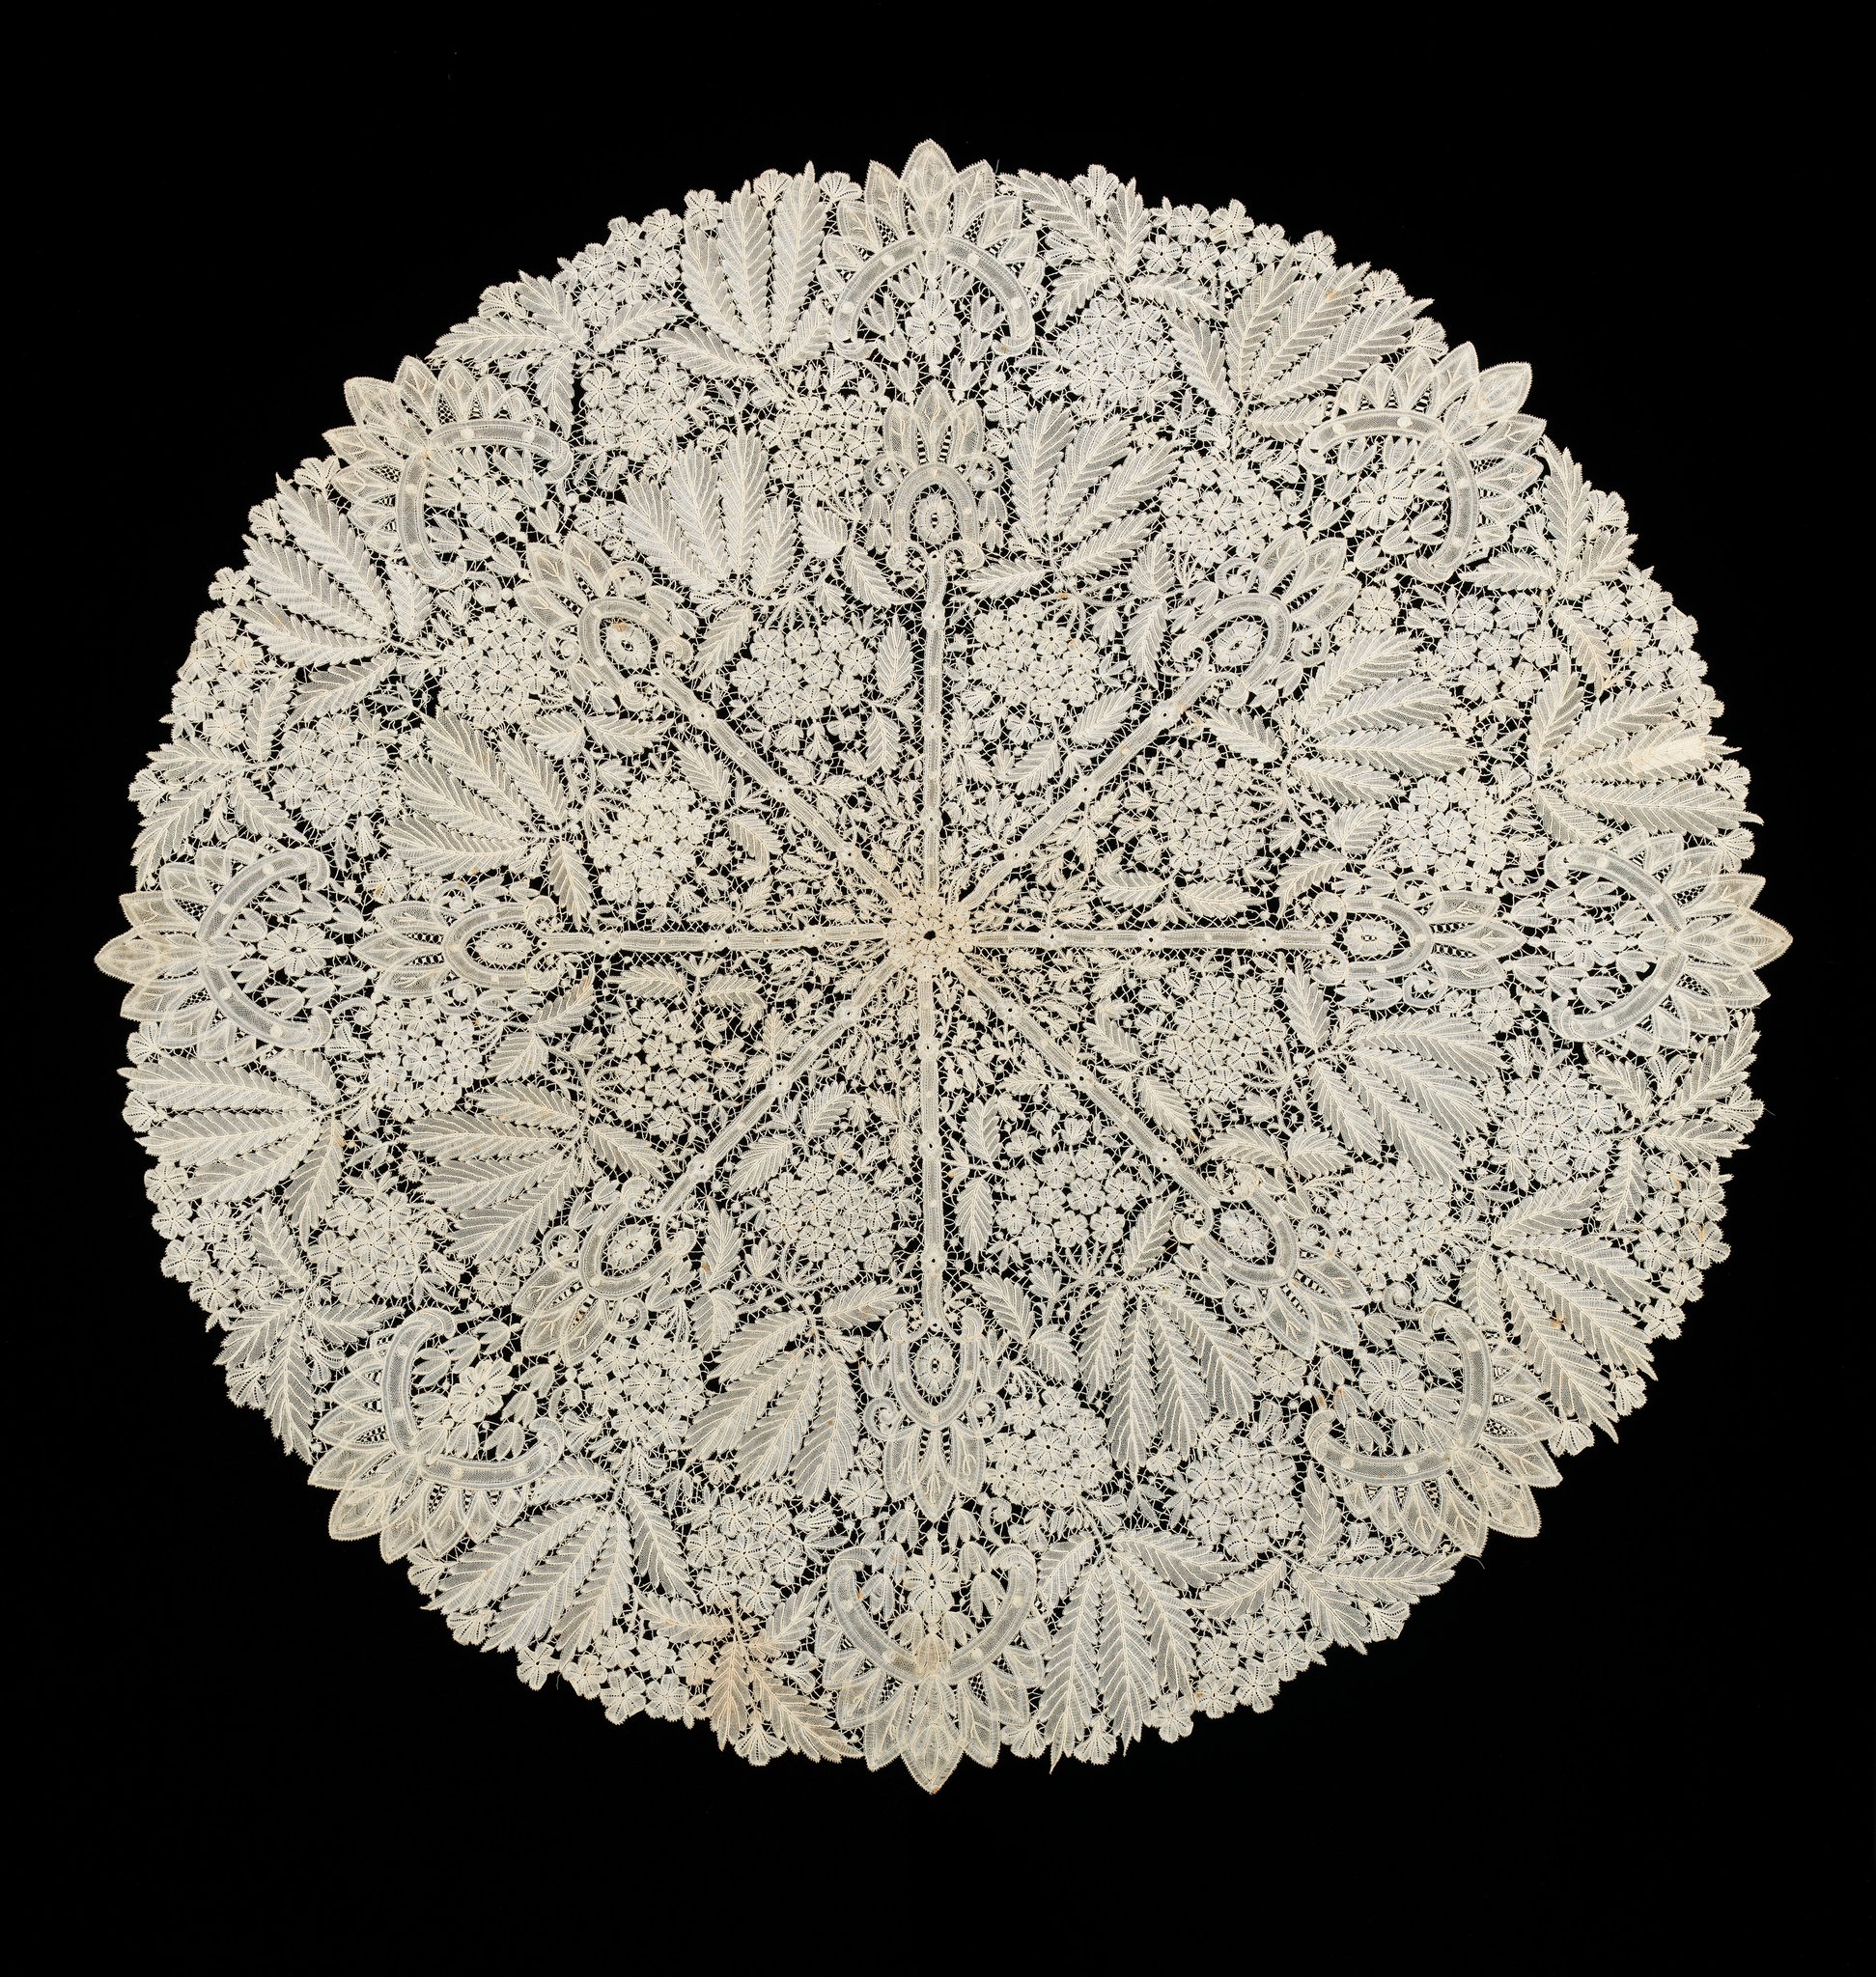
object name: parasol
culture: belgian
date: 1876-1900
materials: linen